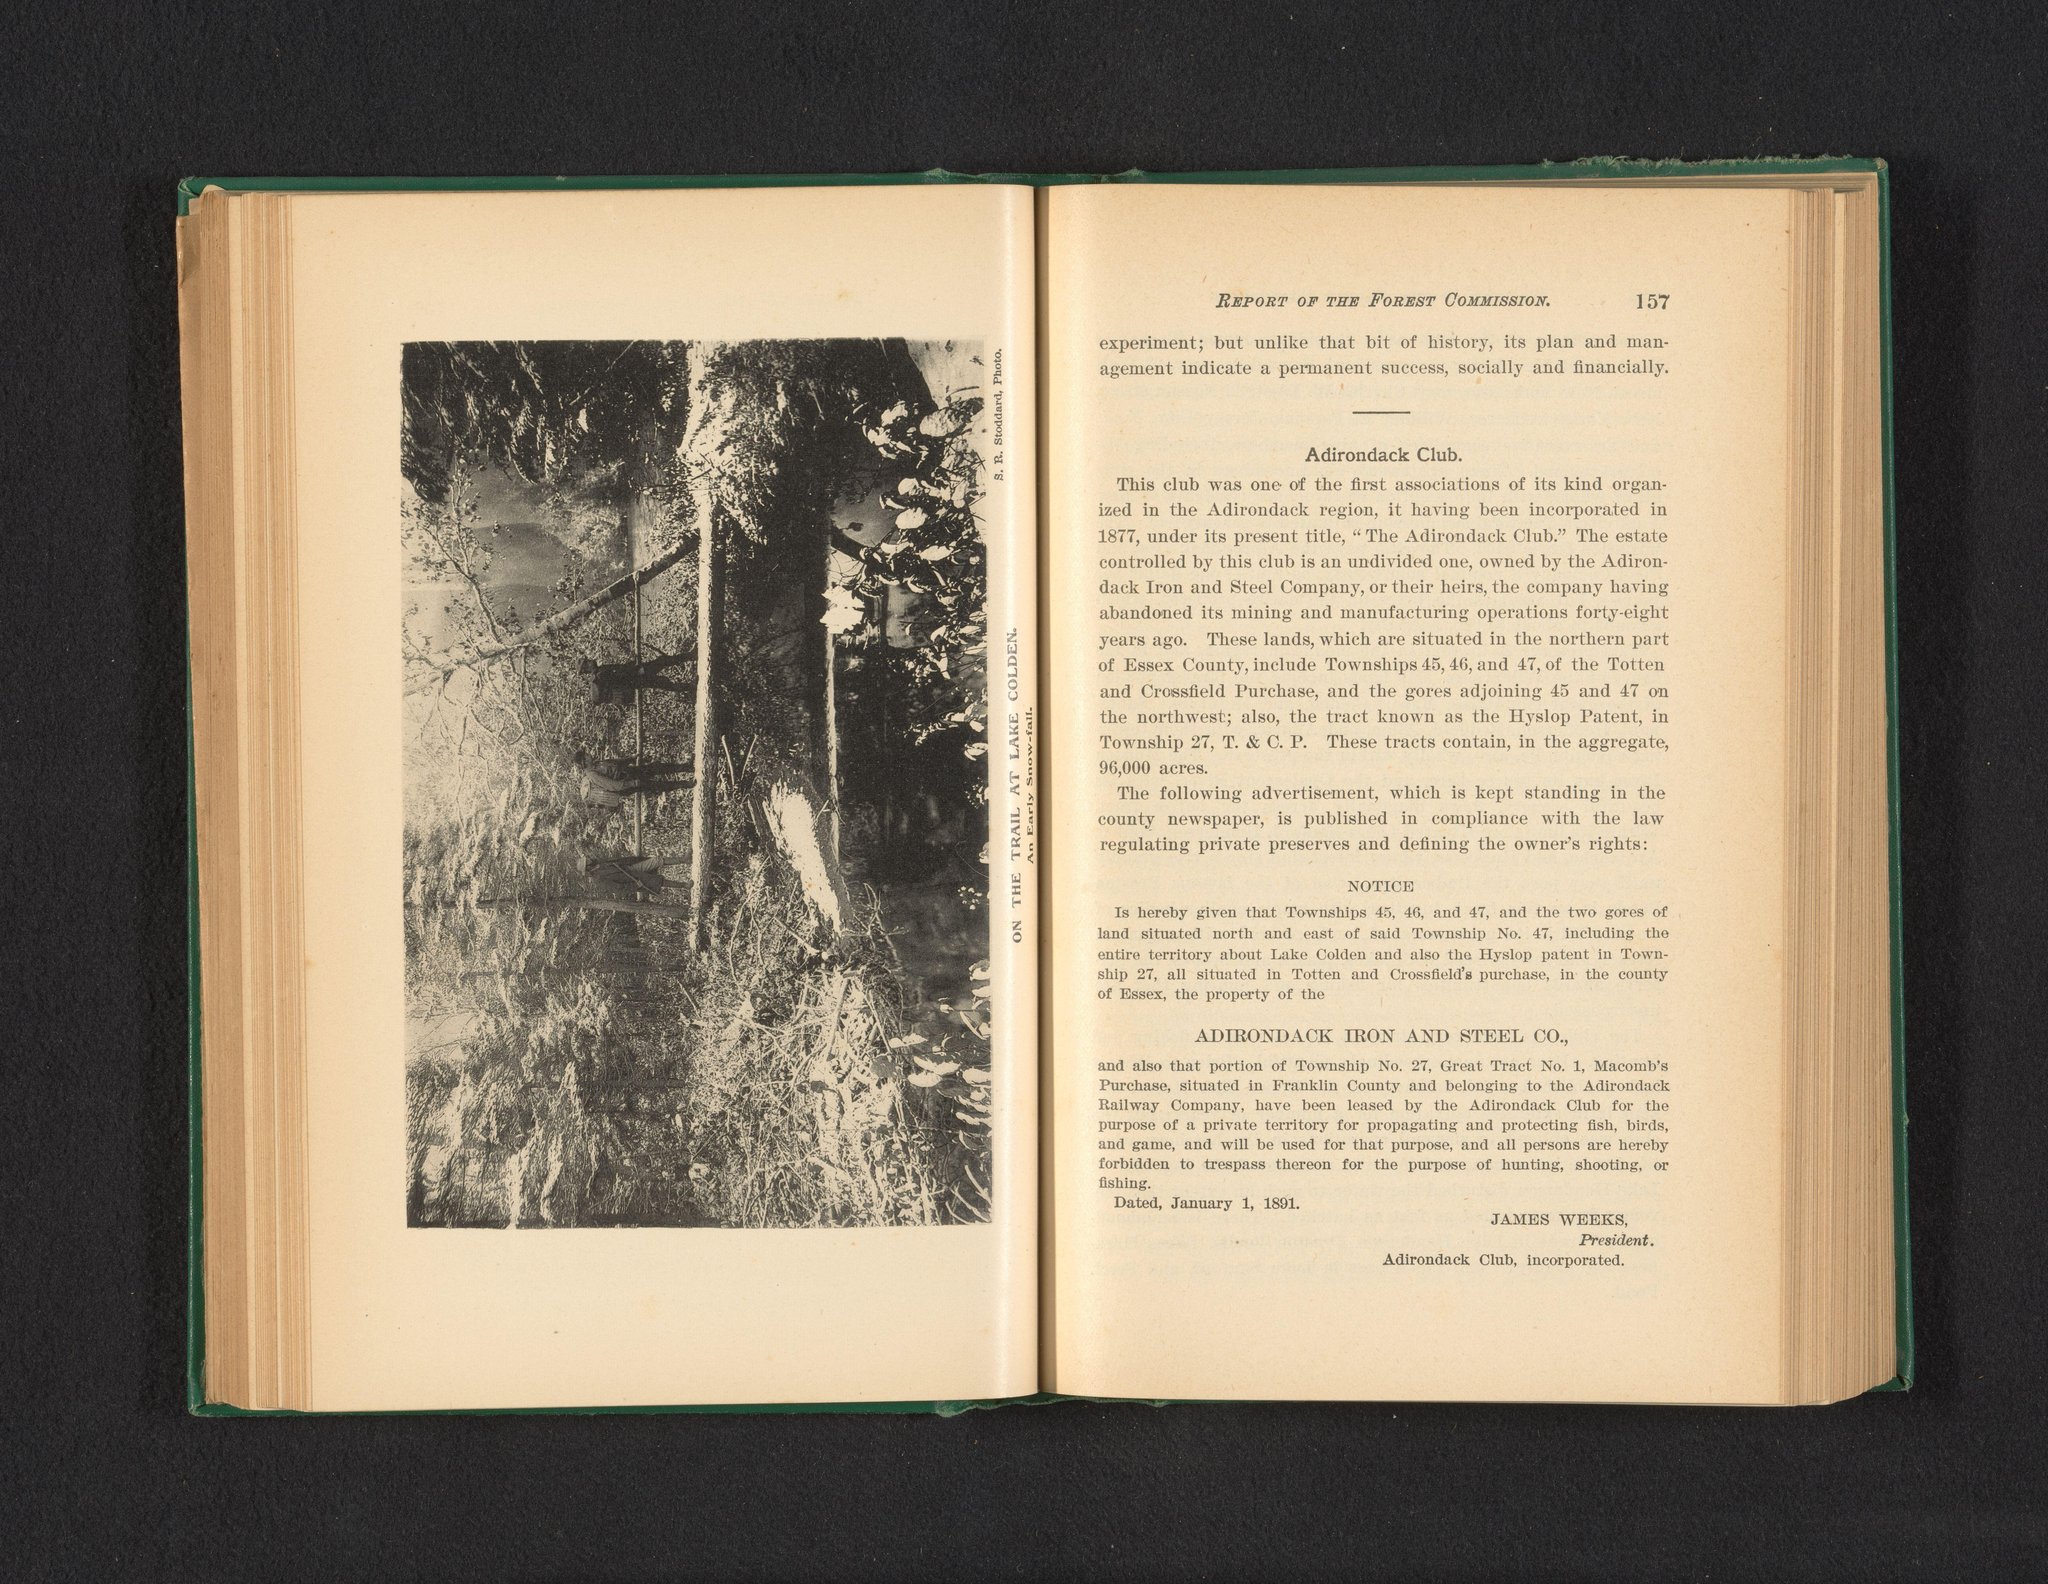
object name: page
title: On the trail at Lake Colden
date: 1893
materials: paper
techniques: photograph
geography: new york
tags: adult man, bridge